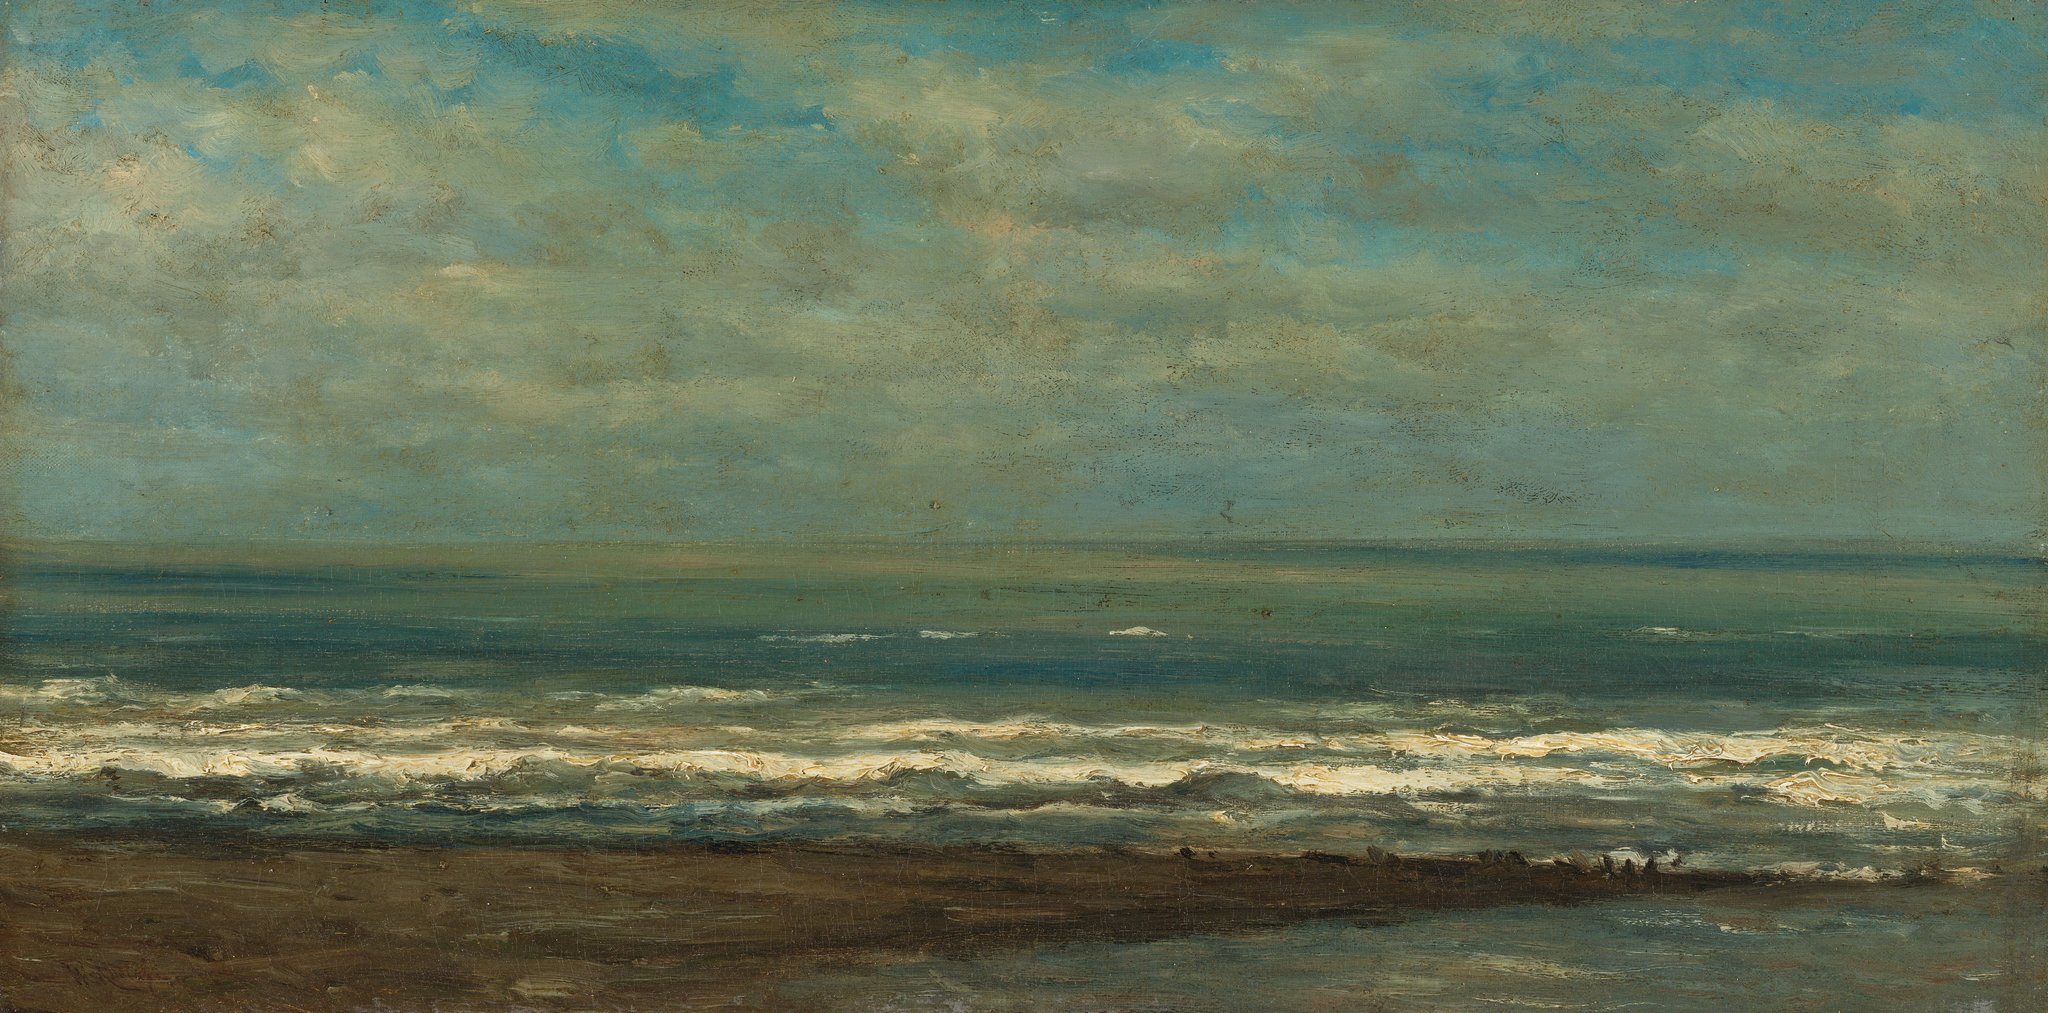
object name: painting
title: Seascape near Heijst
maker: willem roelofs (i)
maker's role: draughtsman, painter, print maker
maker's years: 1822-1897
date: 1868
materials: canvas, oil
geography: netherlands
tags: sea (seascape)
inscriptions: label: ‘W. Roelofs 292’, signature: ‘W. Roelofs’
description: Zeegezicht bij Heijst. Golven van de branding bij het strand, boven het water meeuwen.